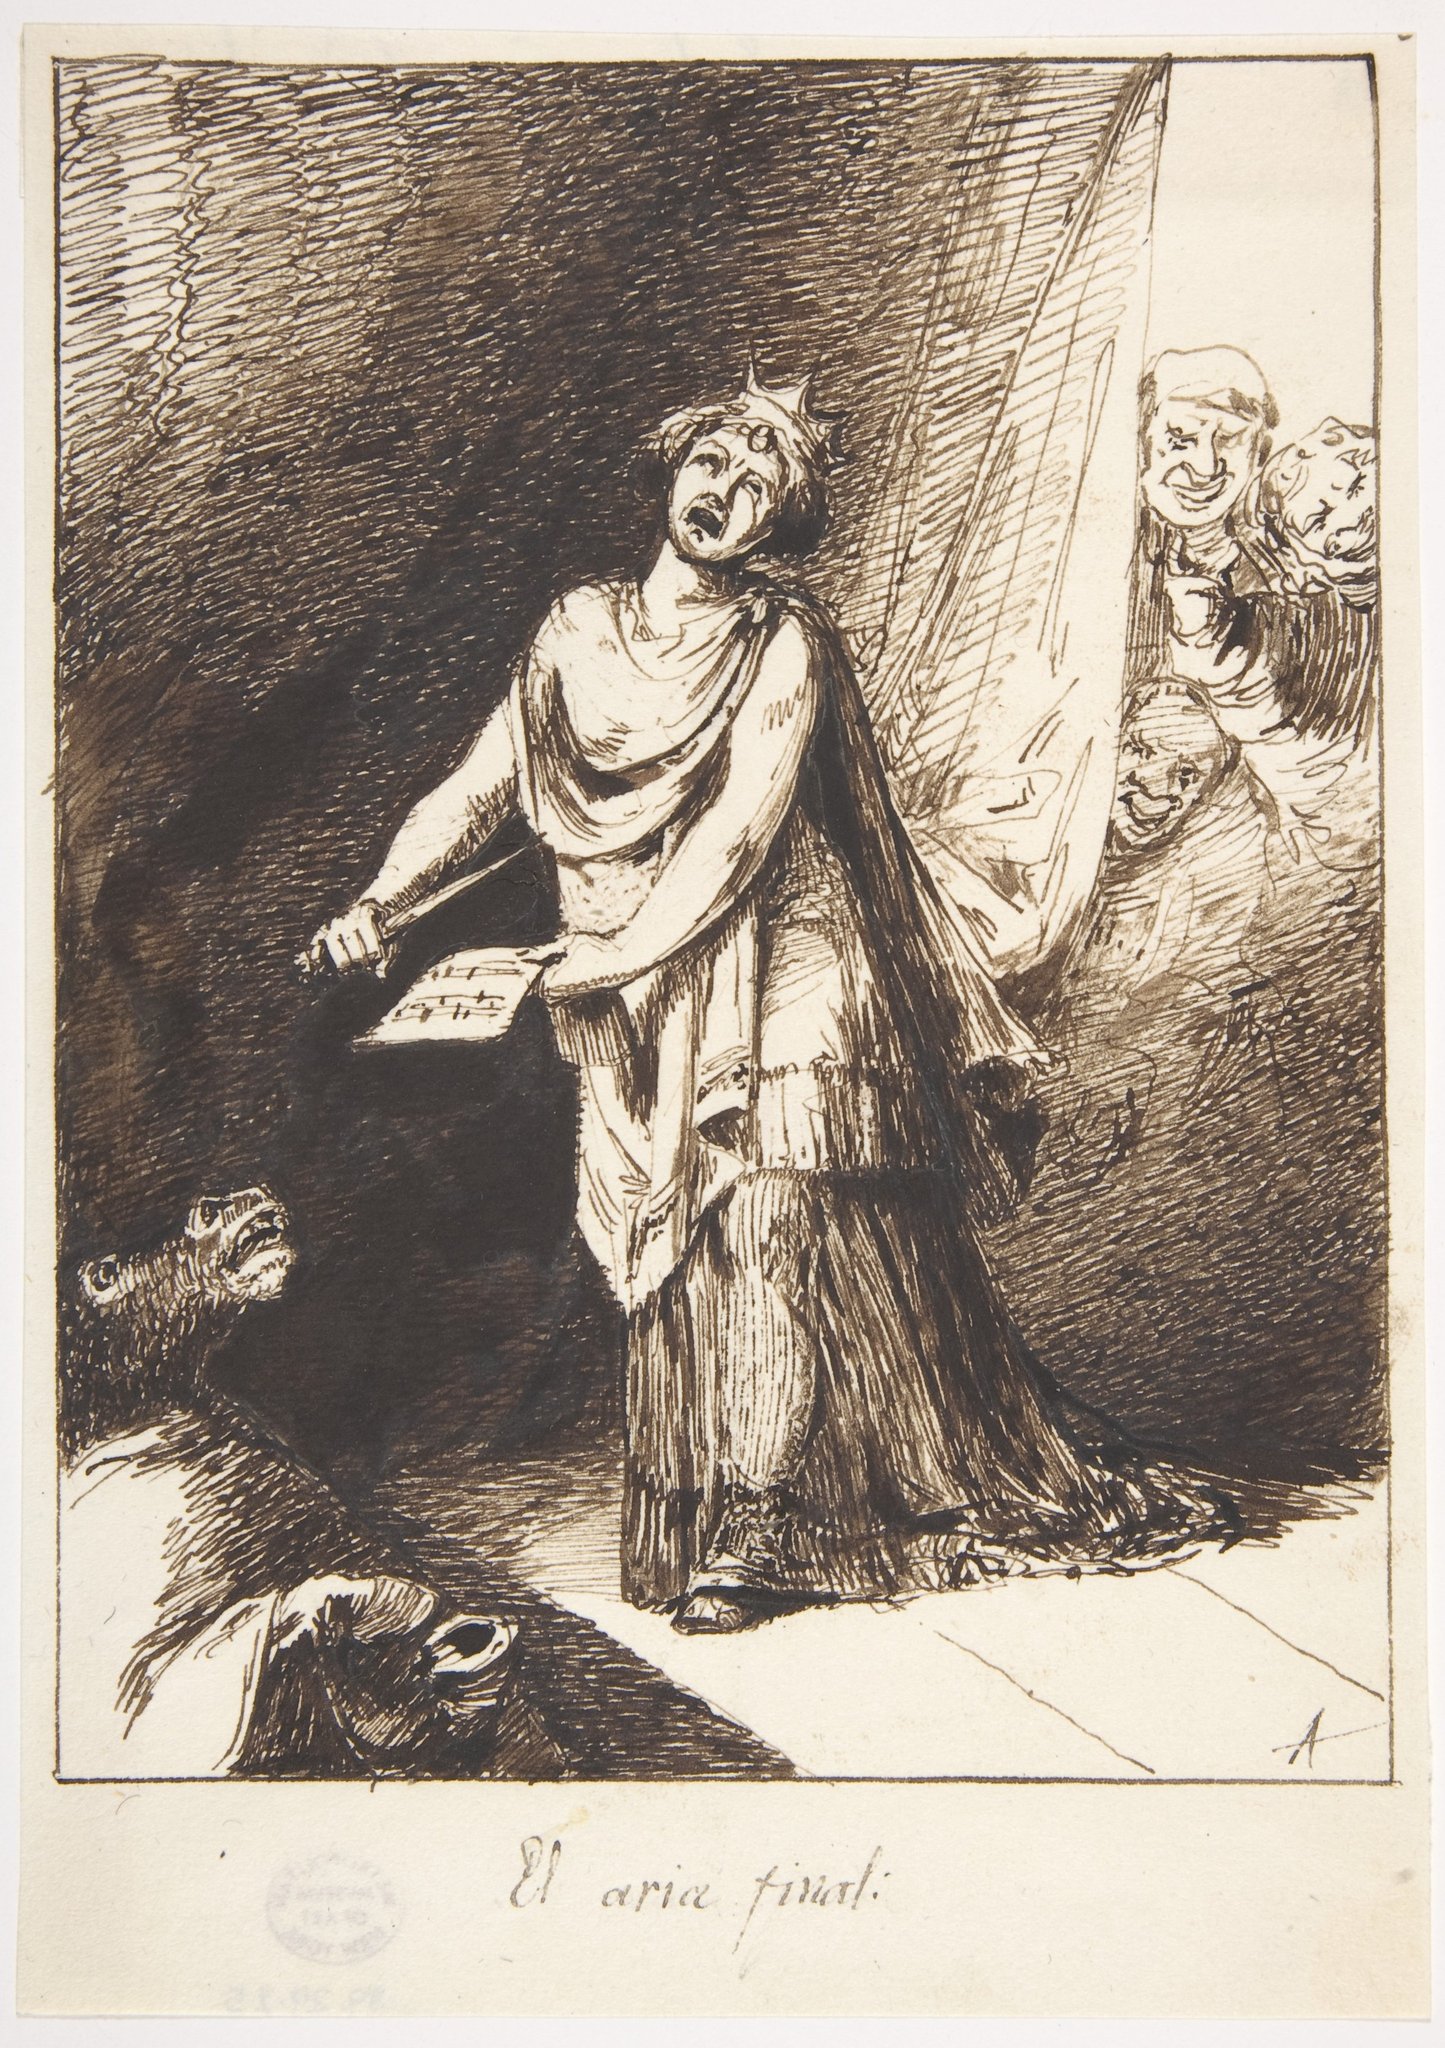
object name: drawing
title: The Last Song (El aria final)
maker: leonardo alenza y nieto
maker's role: artist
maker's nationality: spanish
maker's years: 1807-1845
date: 1807-1845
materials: ink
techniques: pen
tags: knives,men,women